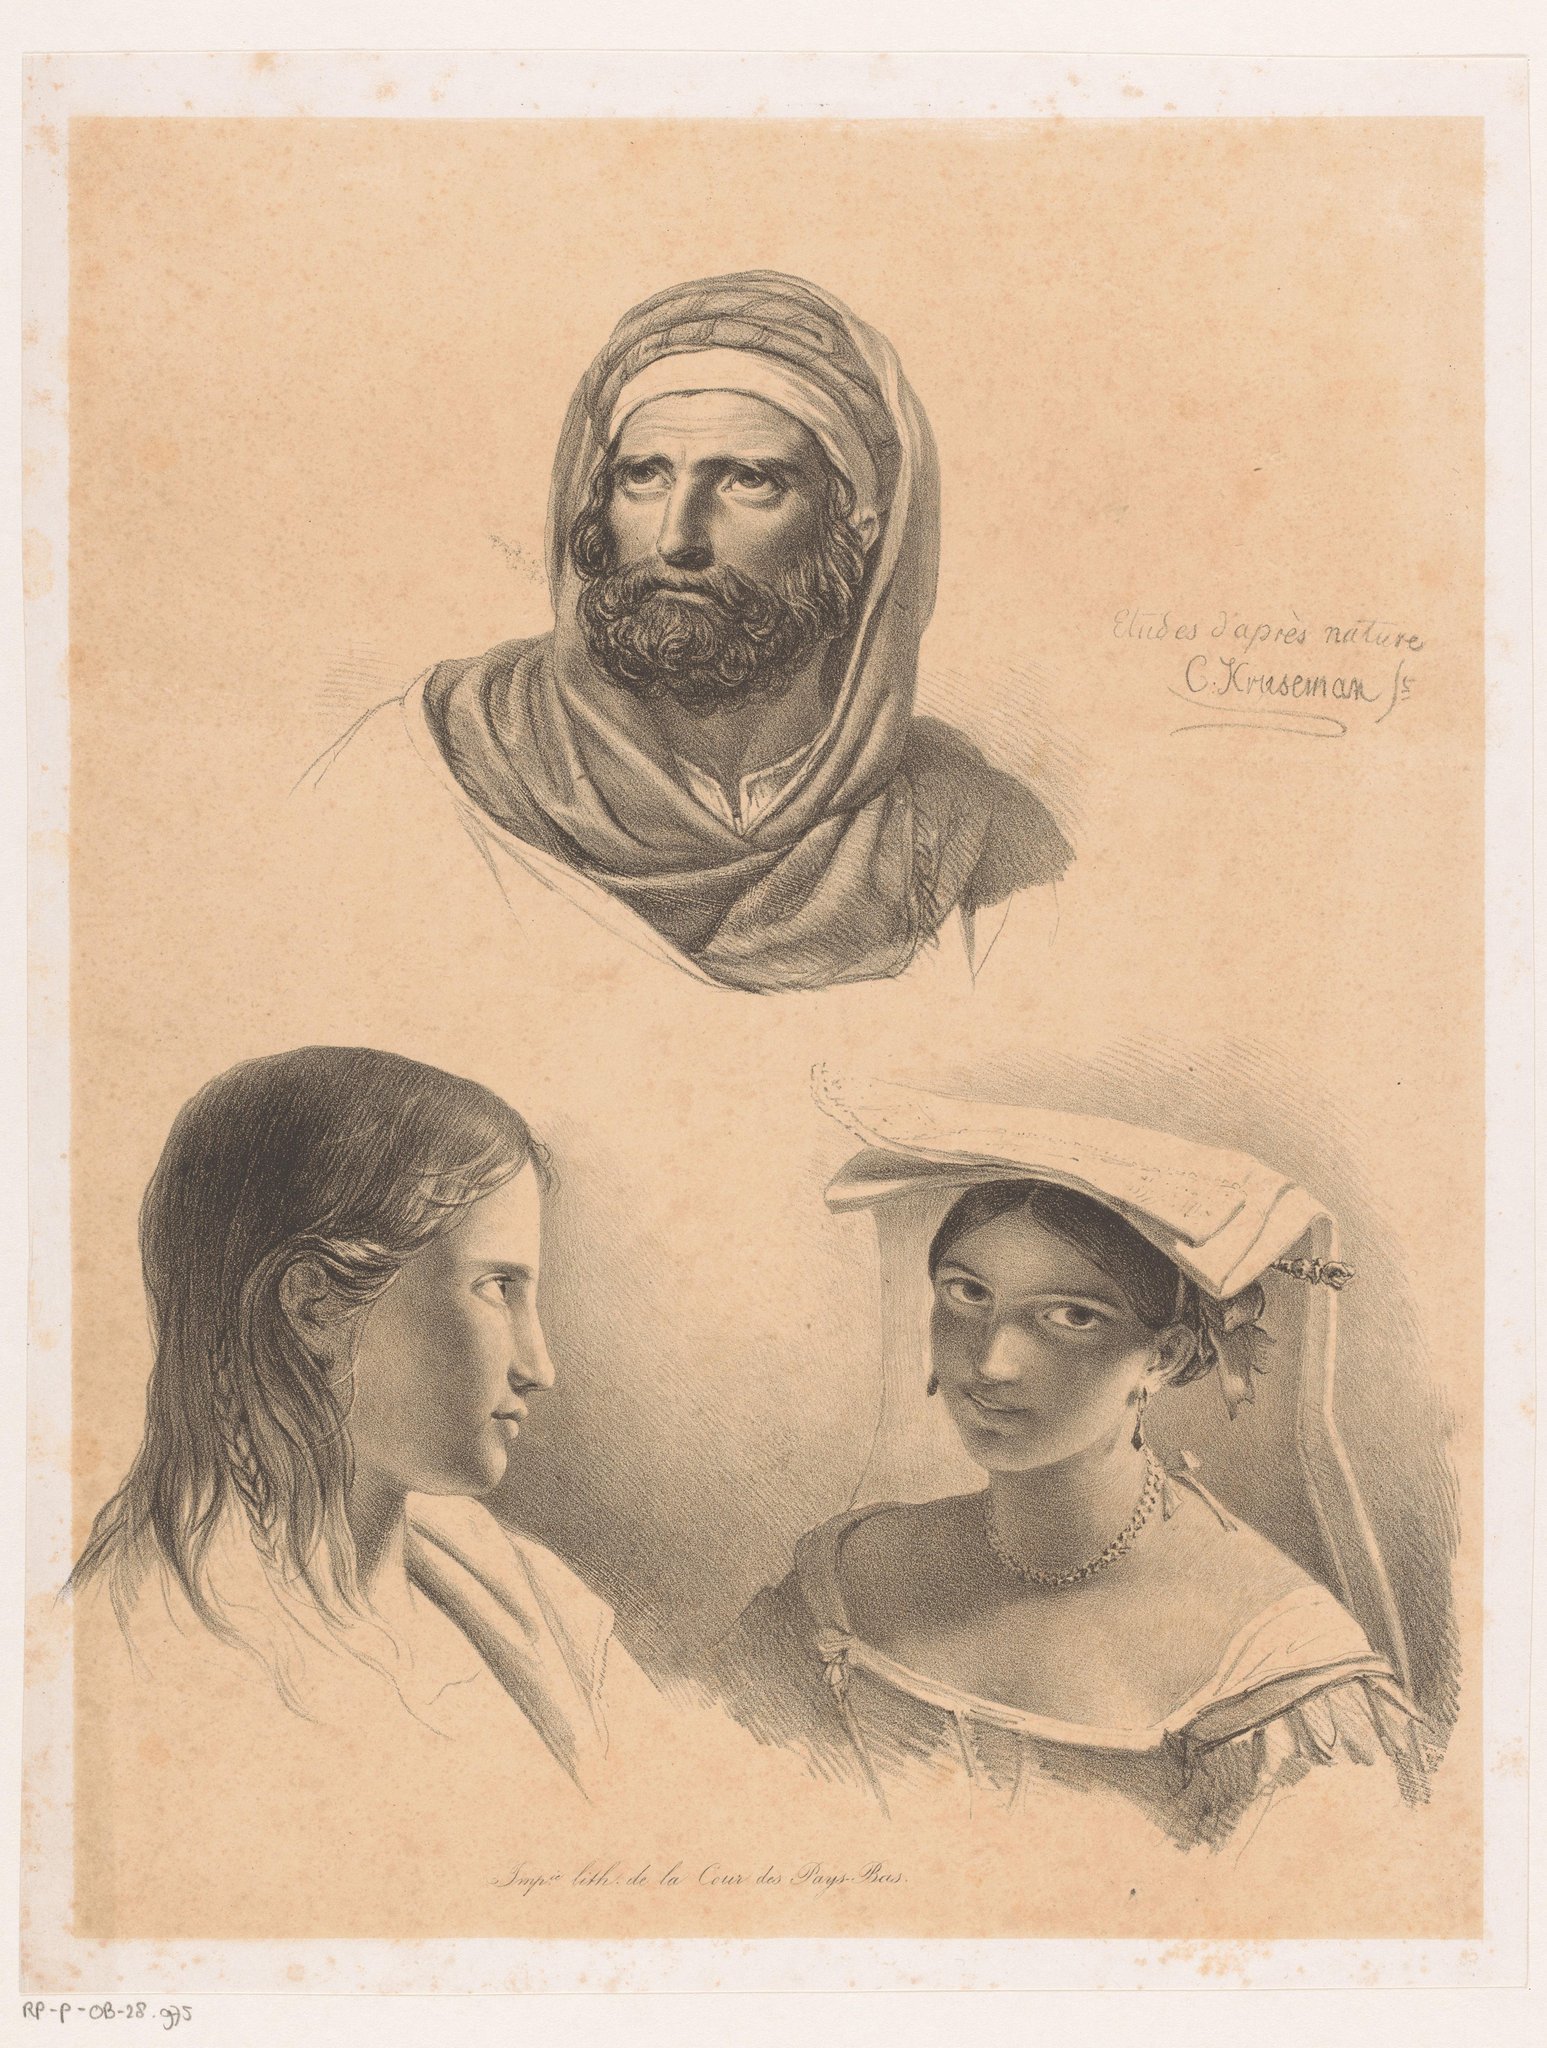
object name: print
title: Drie portretten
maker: cornelis kruseman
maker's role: draughtsman, painter, print maker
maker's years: 1797-1857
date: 1809-1857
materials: paper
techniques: tone lithography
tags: historical persons (+ head (and shoulders) (portrait)), old man, europeans (with name) (+ costume)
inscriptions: collector's mark: Lugt 2228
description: Bovenin een oudere man met een baard, linksonder een meisje of jongen met lang haar en rechtsonder een vrouw in Italiaanse kleding.